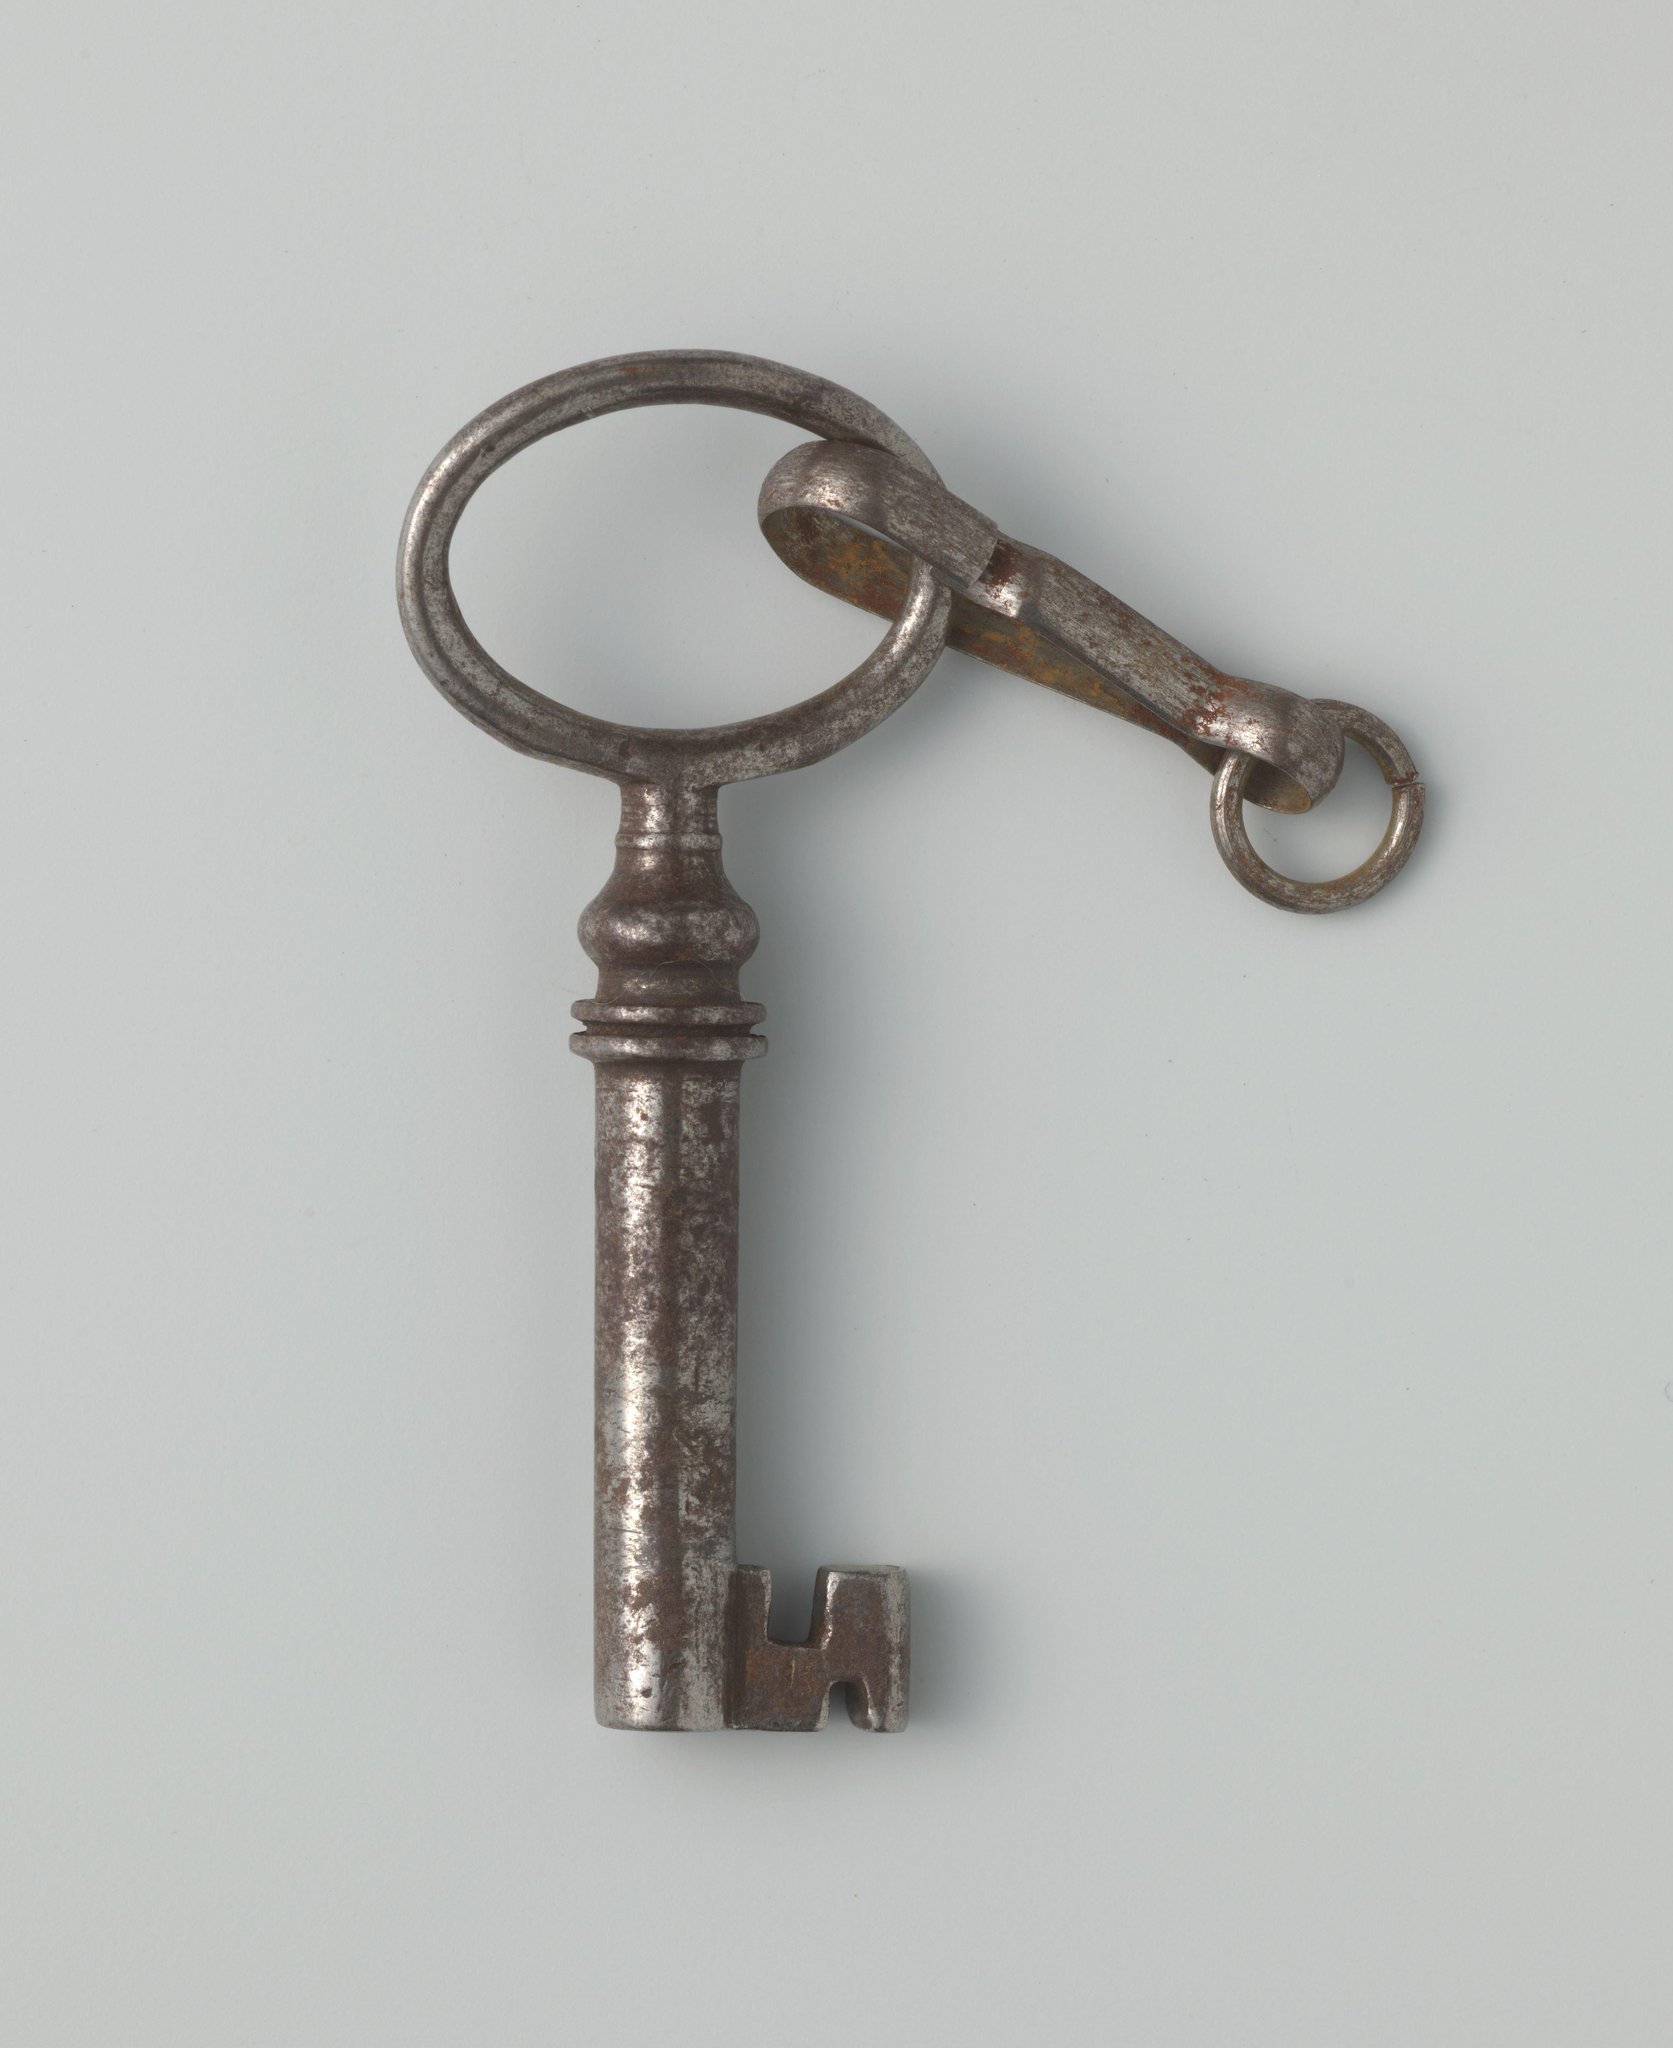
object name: key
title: Sleutel bij mahoniehouten cassette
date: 1806-1832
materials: metal